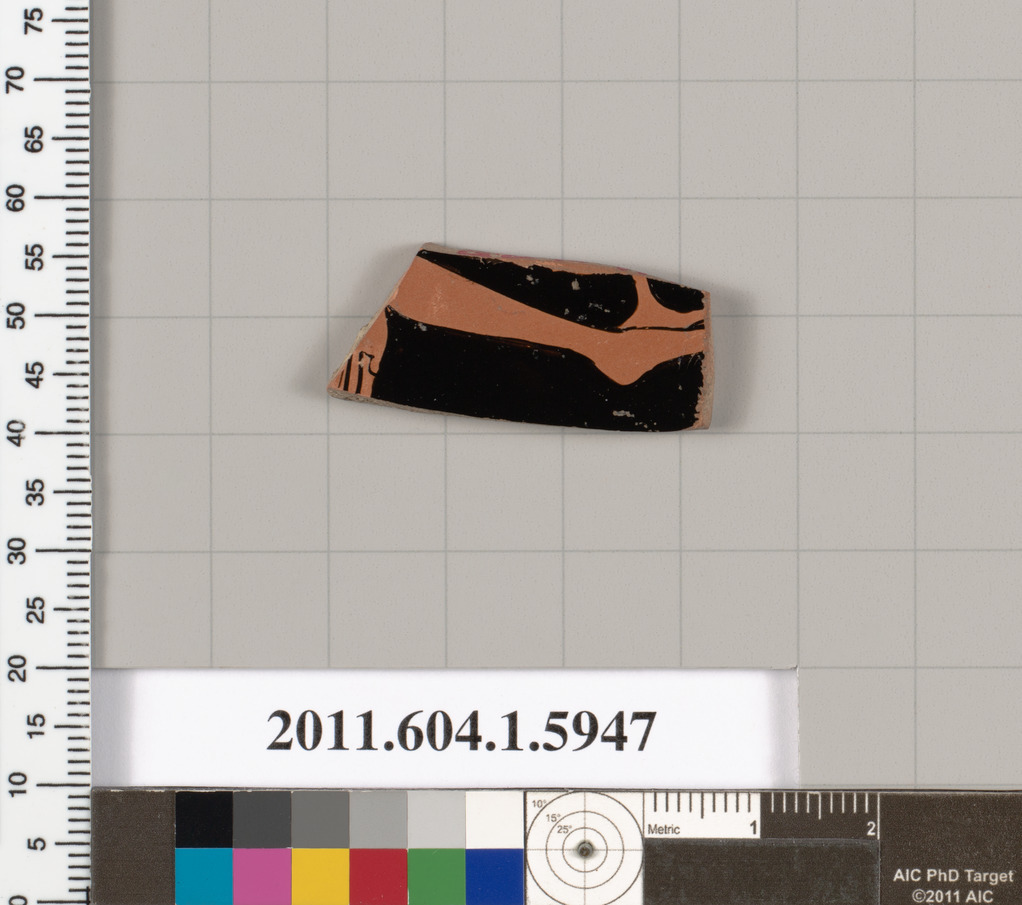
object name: kylix fragment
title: Terracotta fragment of a kylix (drinking cup)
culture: greek, attic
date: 433-567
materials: terracotta